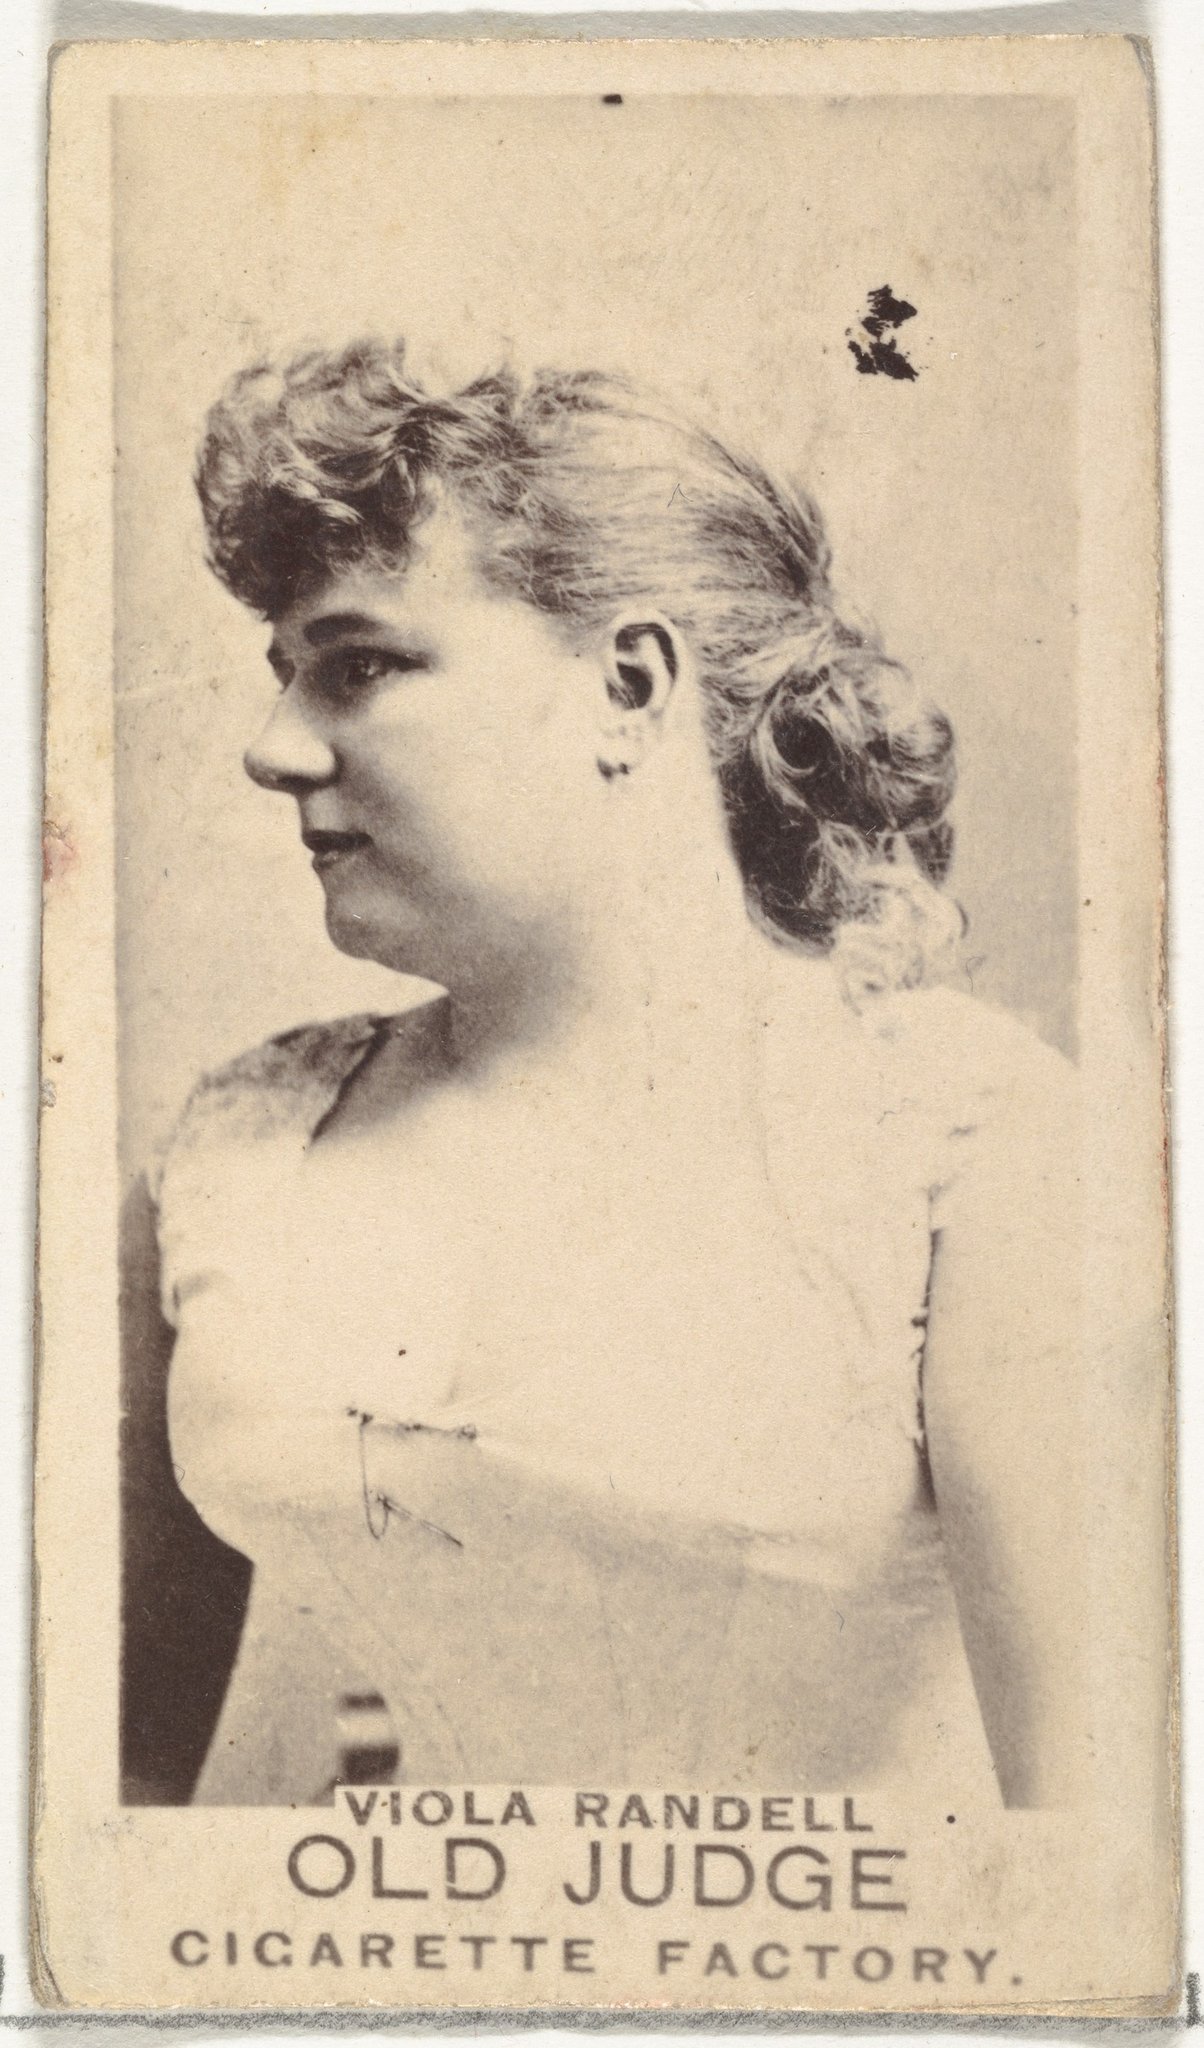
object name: photograph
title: Viola Randell, from the Actors and Actresses series (N171) for Old Judge Cigarettes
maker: goodwin & company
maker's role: publisher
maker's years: 1850-1950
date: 1886-1890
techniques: albumen silver print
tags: portraits,women,actresses